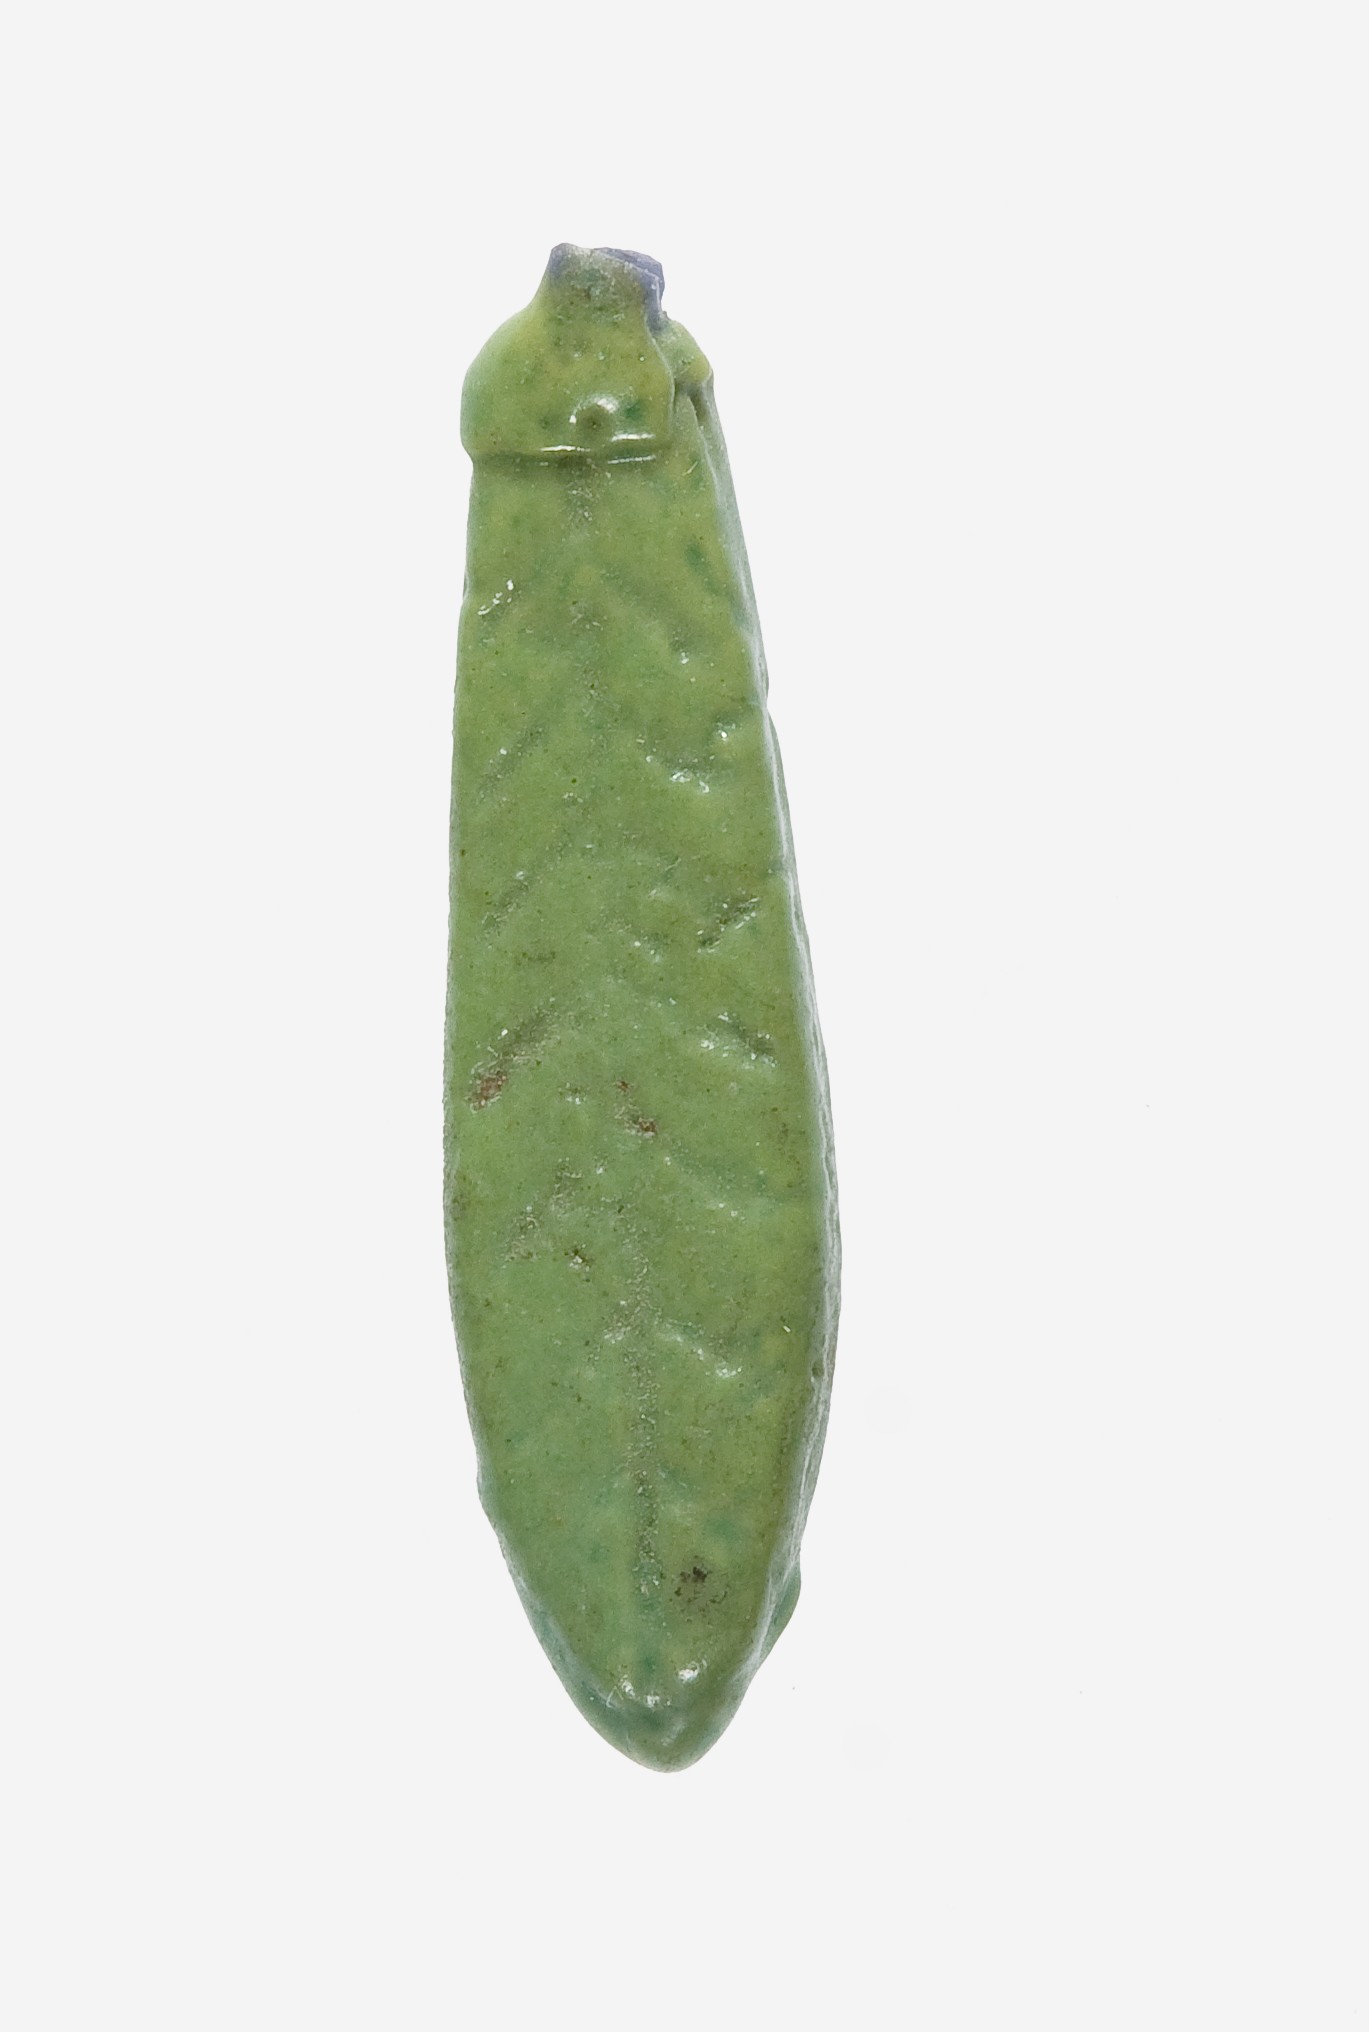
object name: pendant, leaf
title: Leaf Pendant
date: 1390-1352 BCE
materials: faience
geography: egypt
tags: leaves